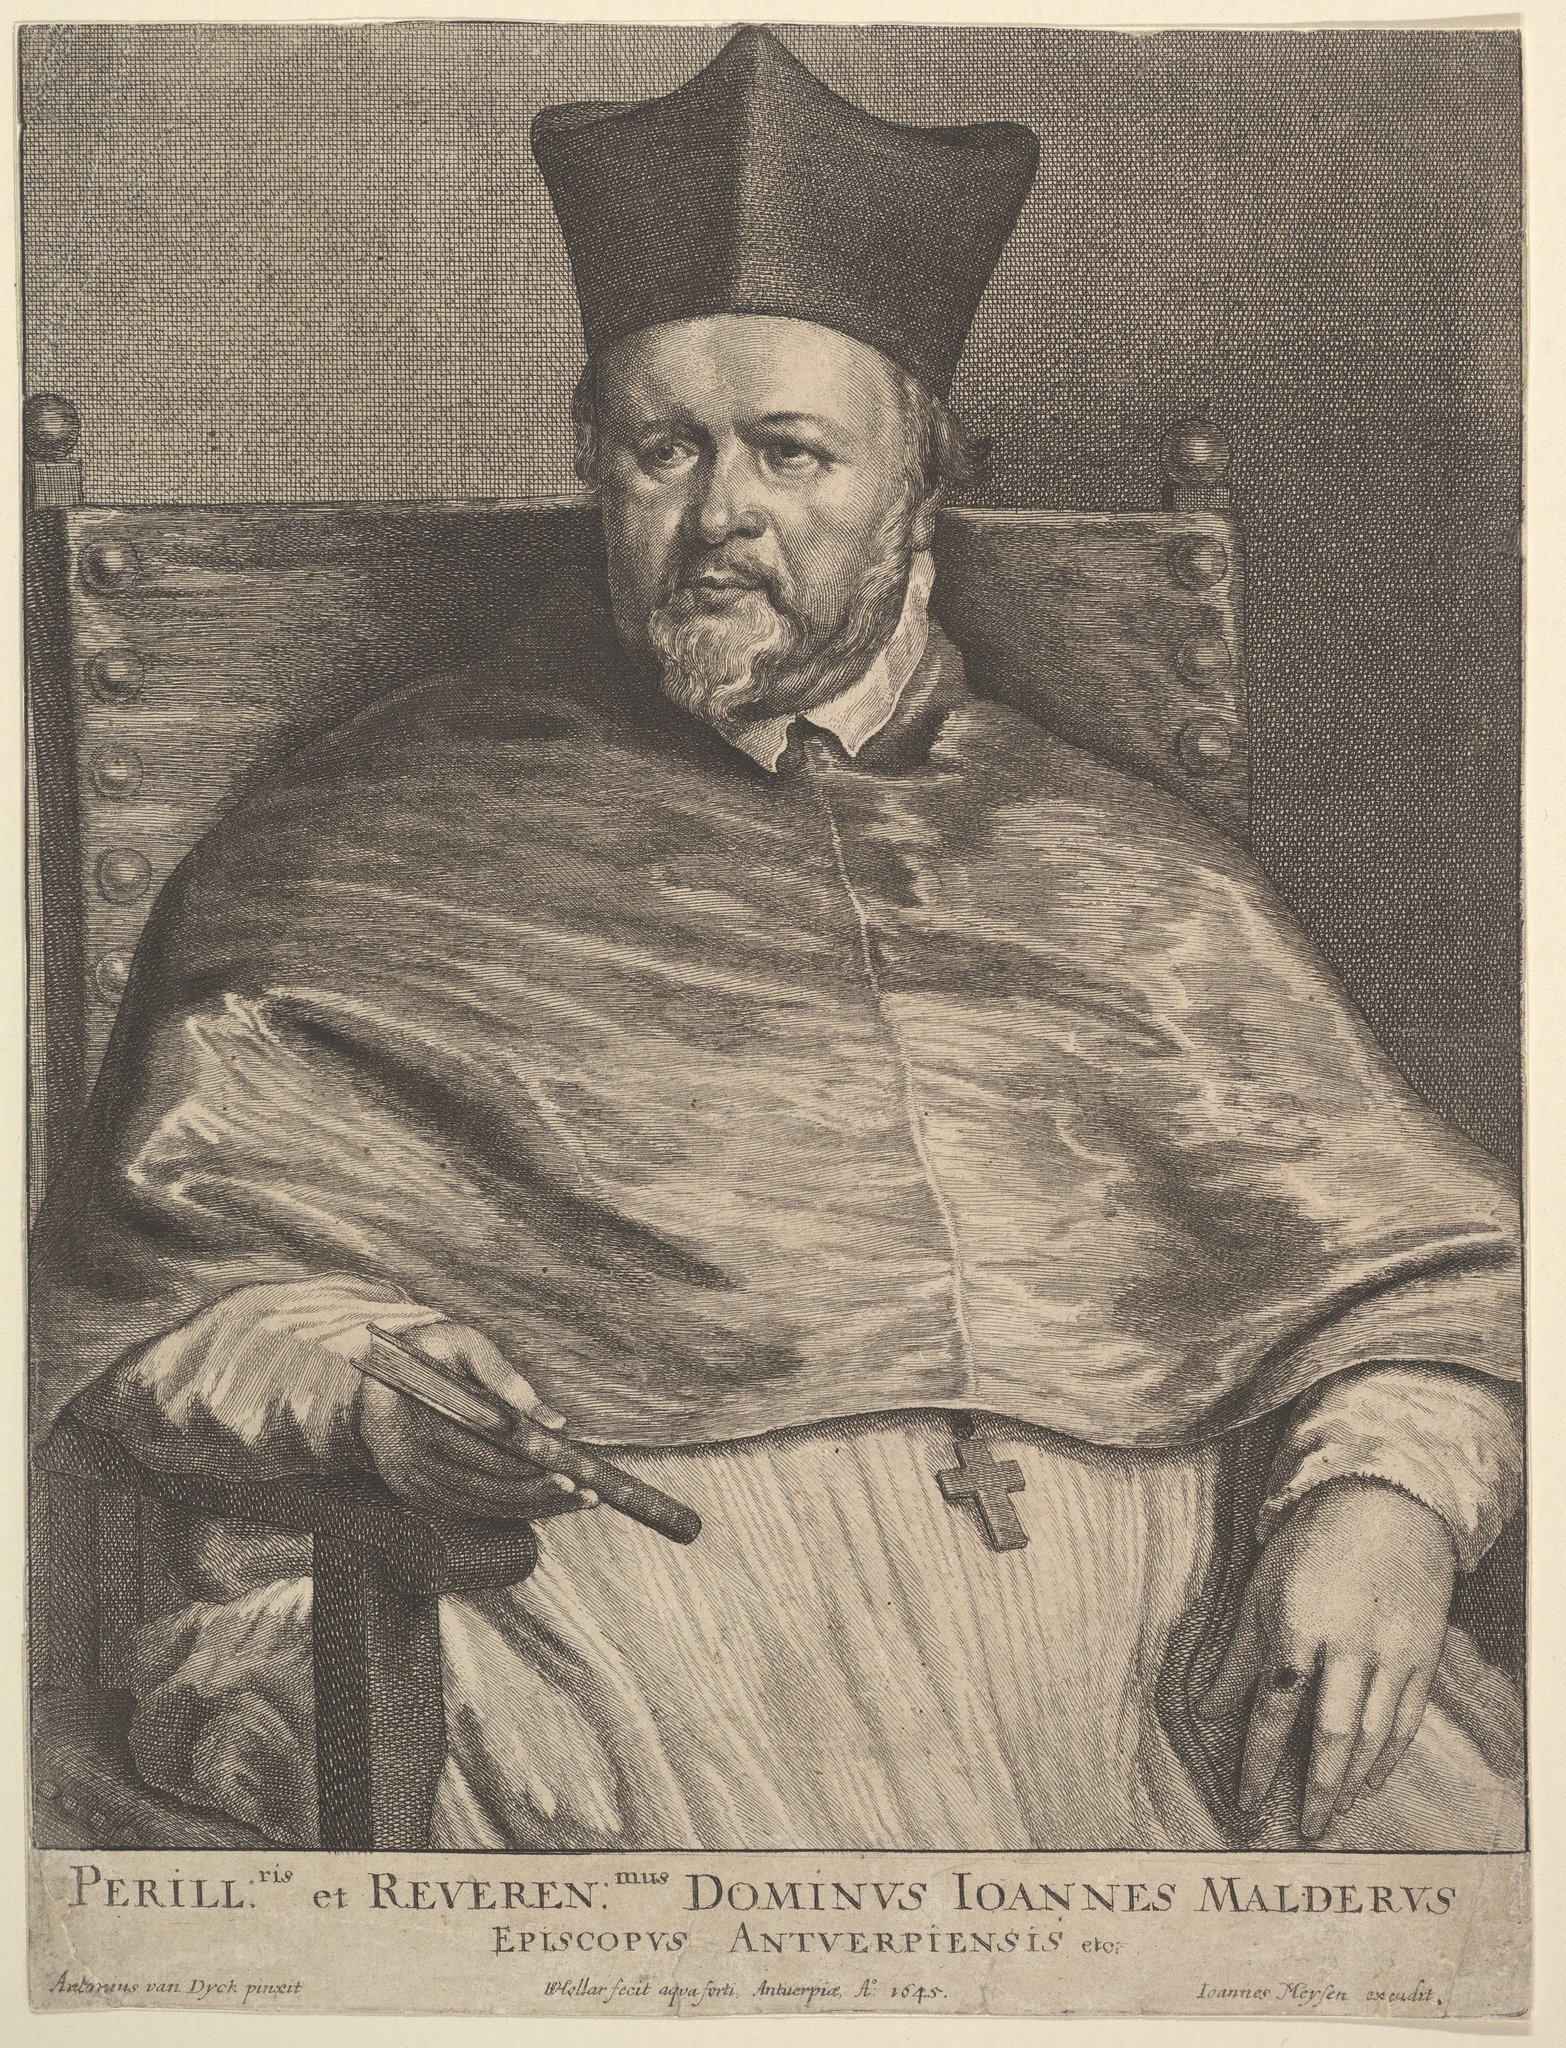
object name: print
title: Bishop Jan van Malderus (Malderen)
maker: wenceslaus hollar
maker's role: artist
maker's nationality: bohemian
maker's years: 1607-1677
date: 1645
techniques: etching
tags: men,portraits,bishops